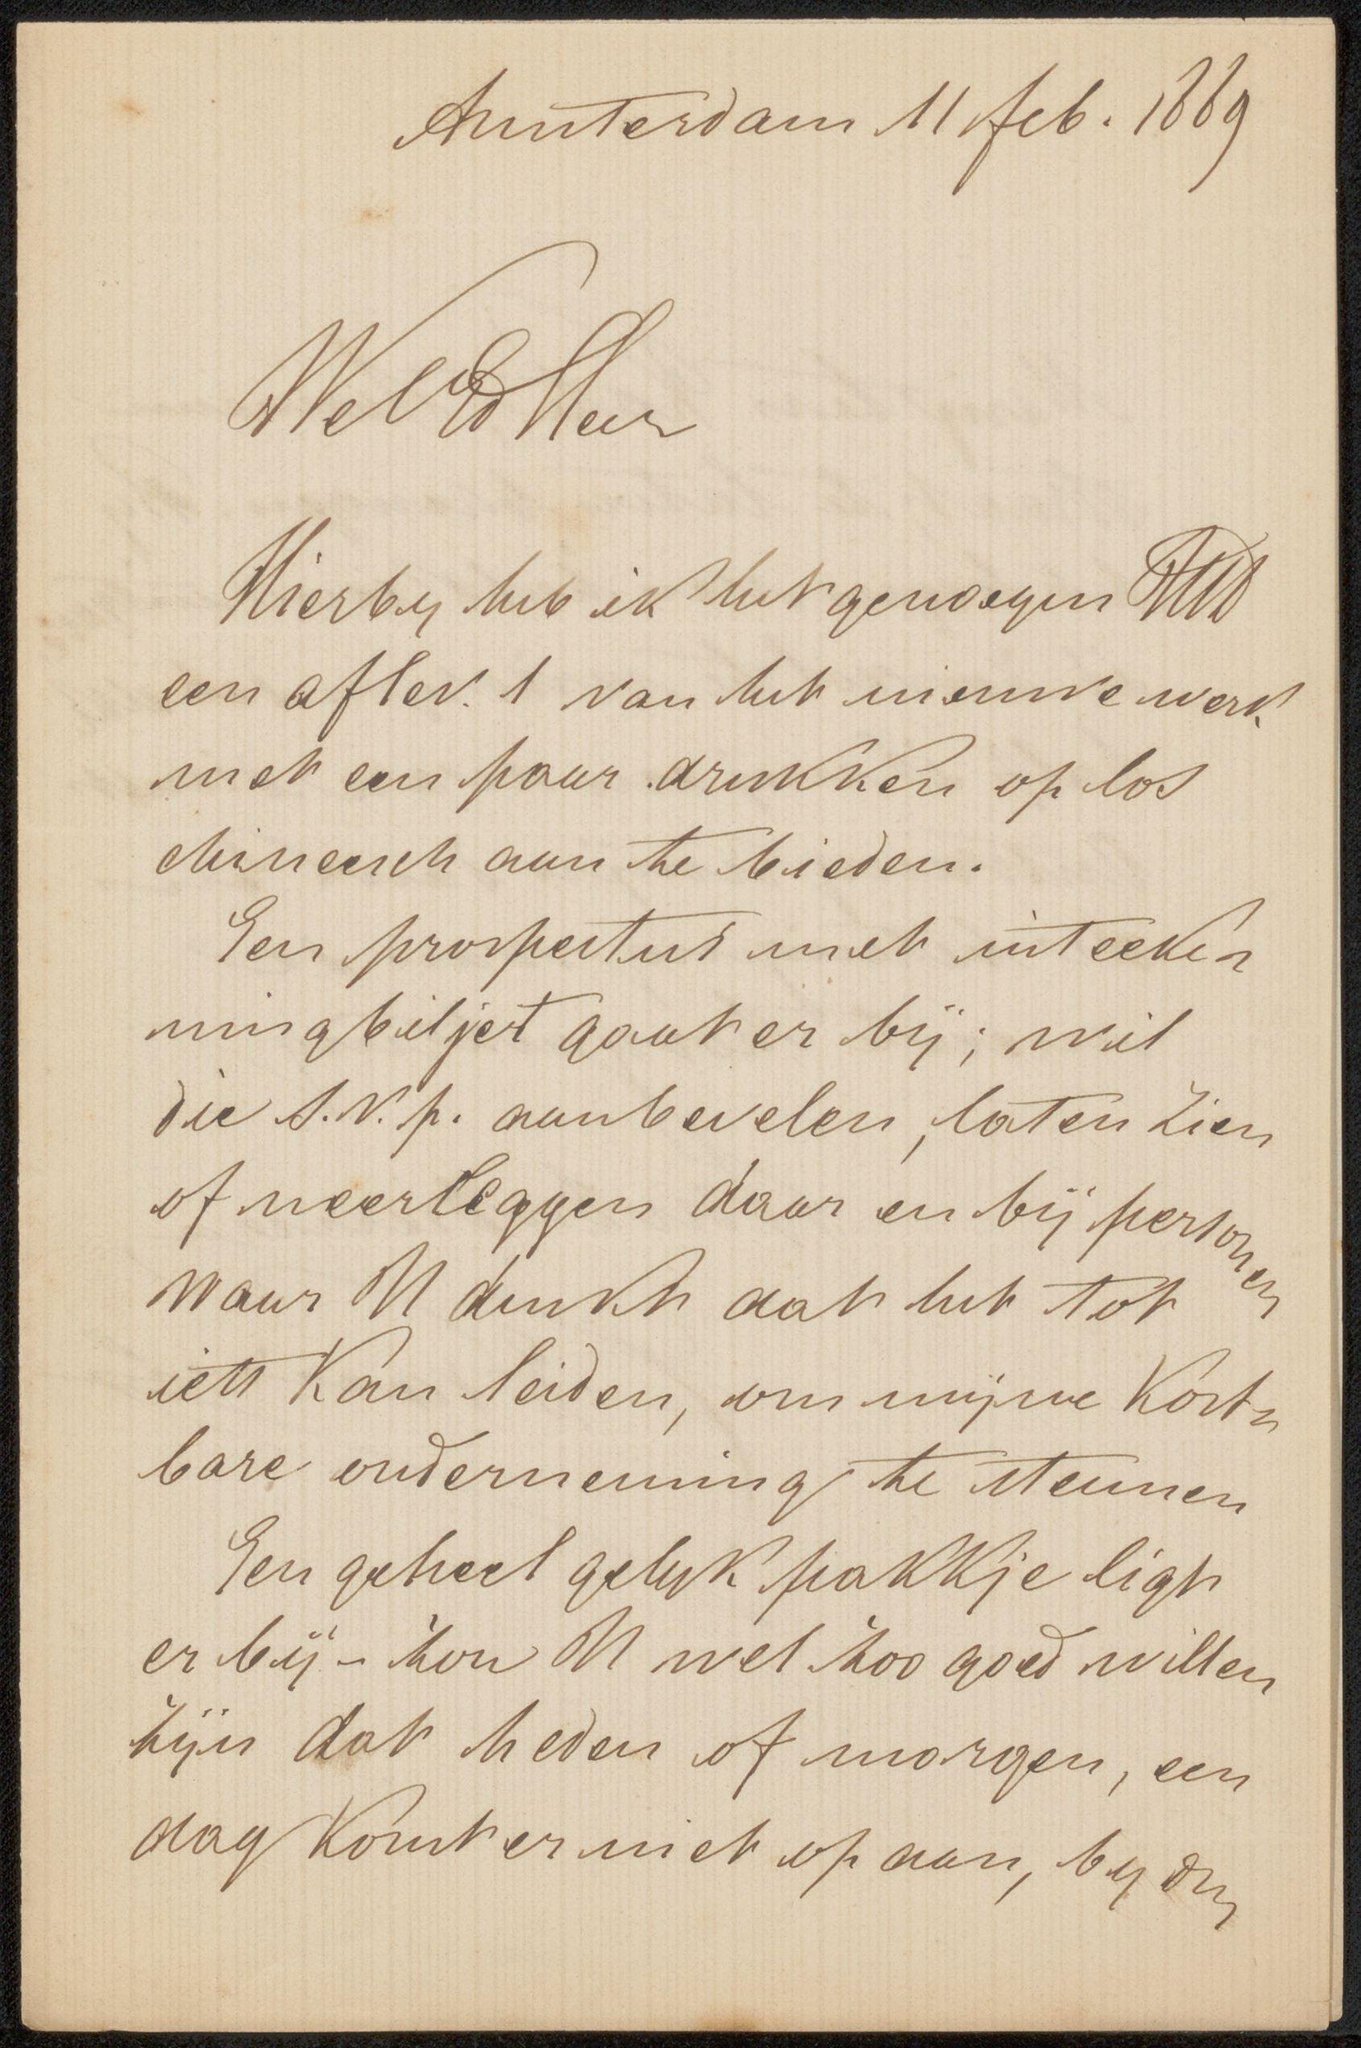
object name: letter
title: Brief aan Philip Zilcken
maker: edouard taurel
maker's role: draughtsman, print maker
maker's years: 1824-1892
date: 1889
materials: ink, paper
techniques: pen, writing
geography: amsterdam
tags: the hague, painter, philip zilcken, the graphic arts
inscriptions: collector's mark: ‘RPK’